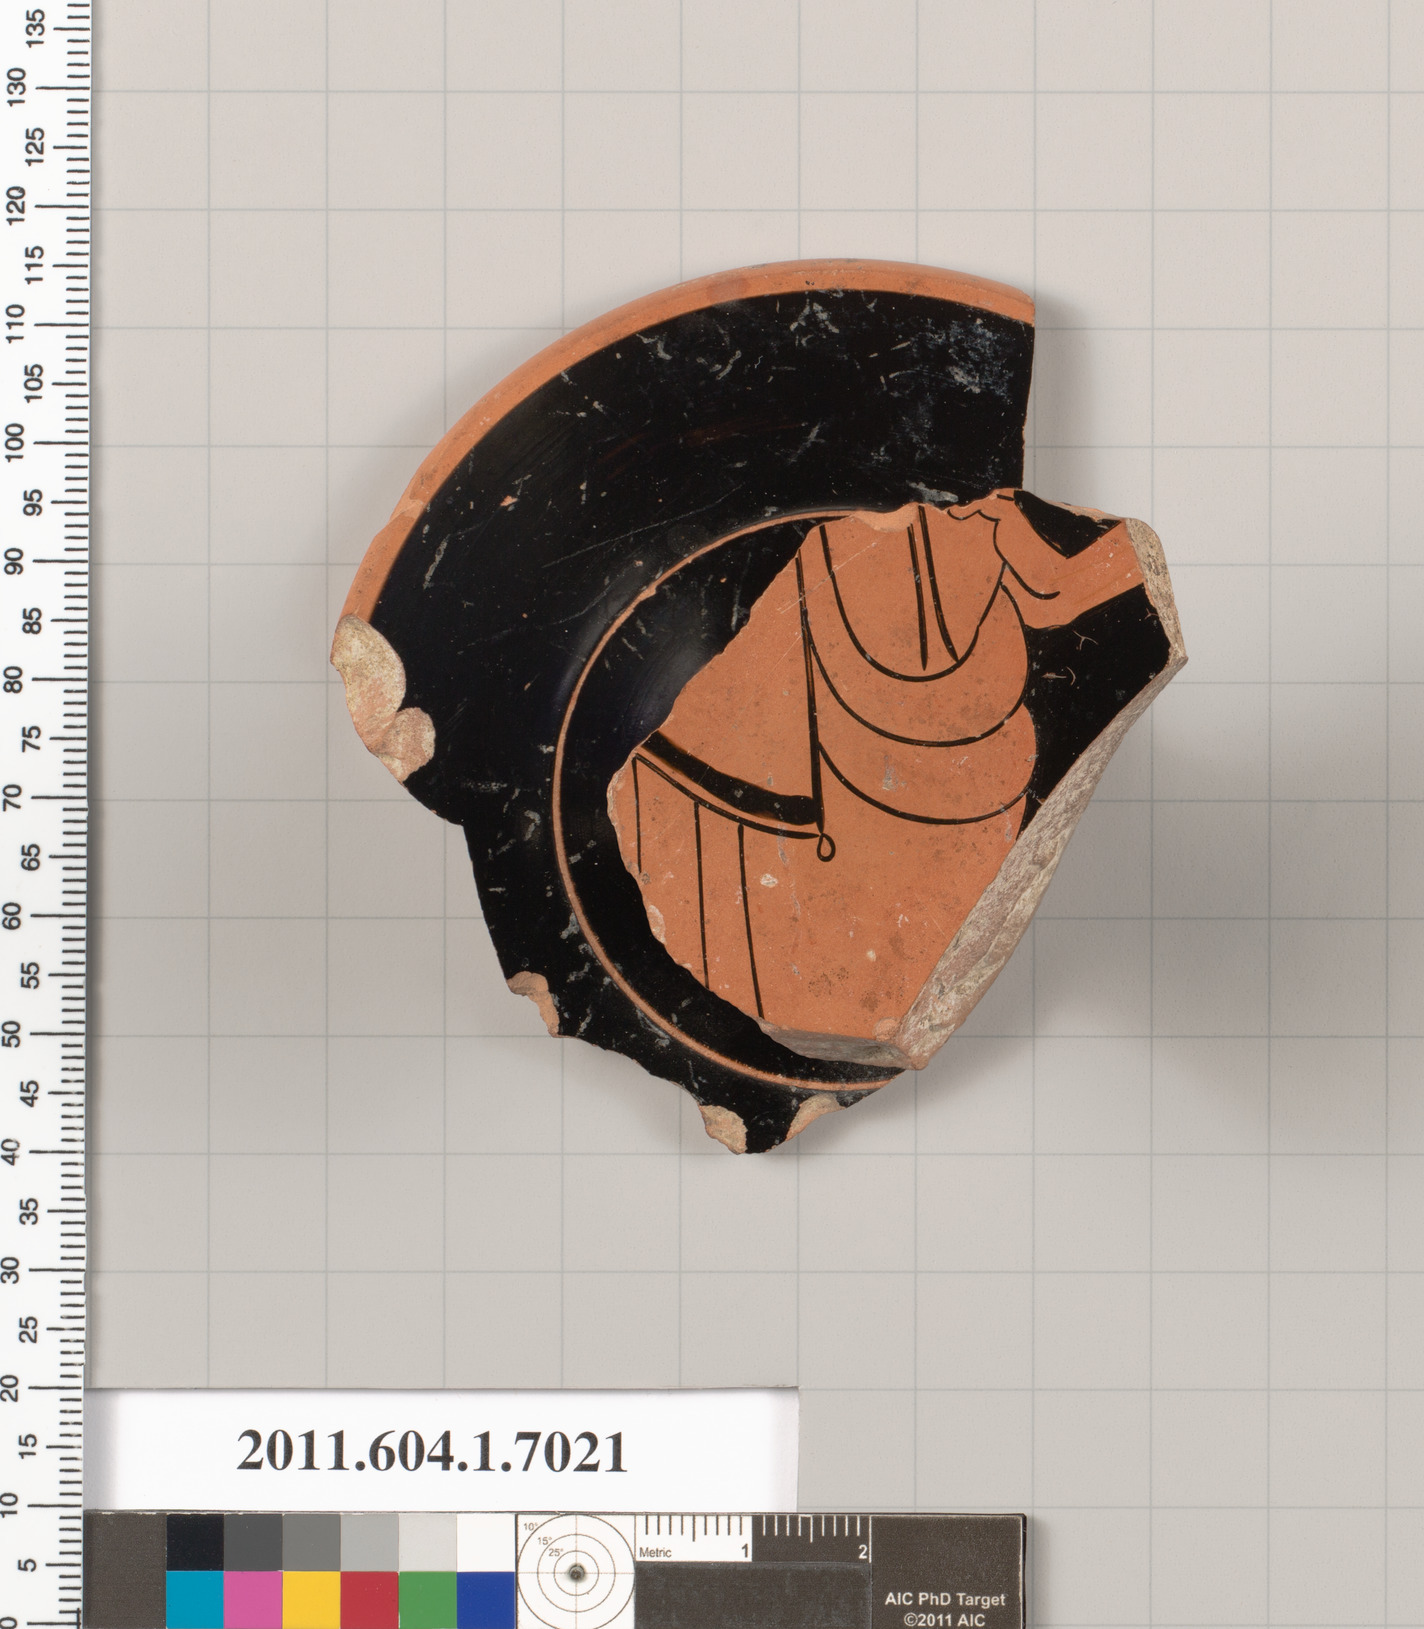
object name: kylix fragment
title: Terracotta fragment of a kylix (drinking cup)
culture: greek, attic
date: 500-480 BCE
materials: terracotta